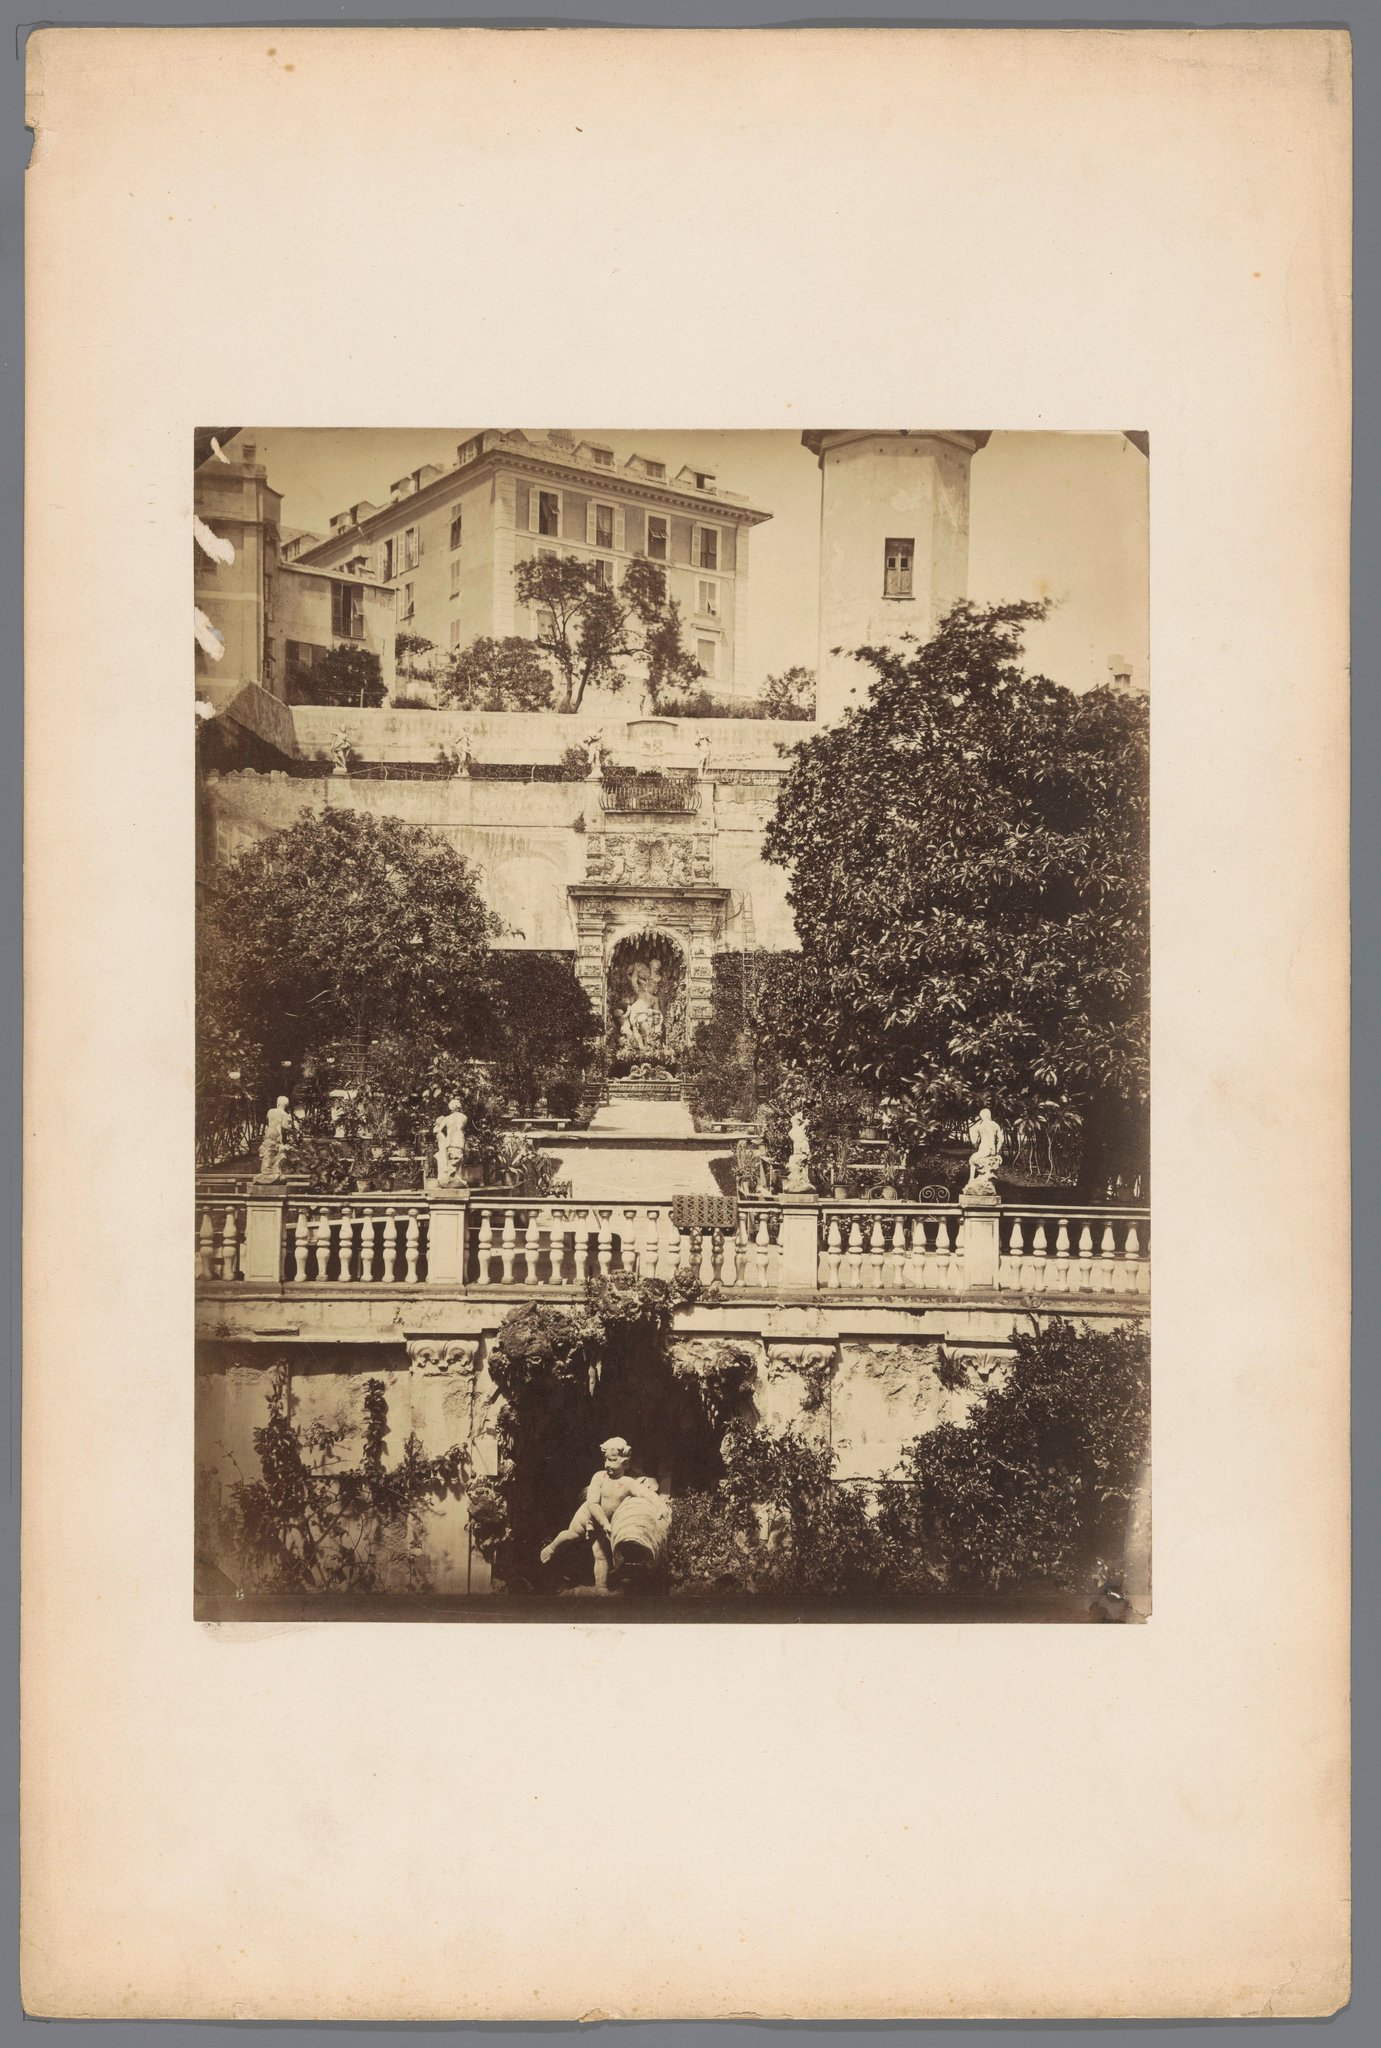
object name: photograph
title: Tuin van een villa (vermoedelijk) te Tivoli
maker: gustave eugène chauffourier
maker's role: fotograaf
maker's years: 1845-1919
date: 1875-1900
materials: photographic support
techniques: albumen print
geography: tivoli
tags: garden, ornamental fountain, sculpture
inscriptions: collector's mark: Lugt 3937